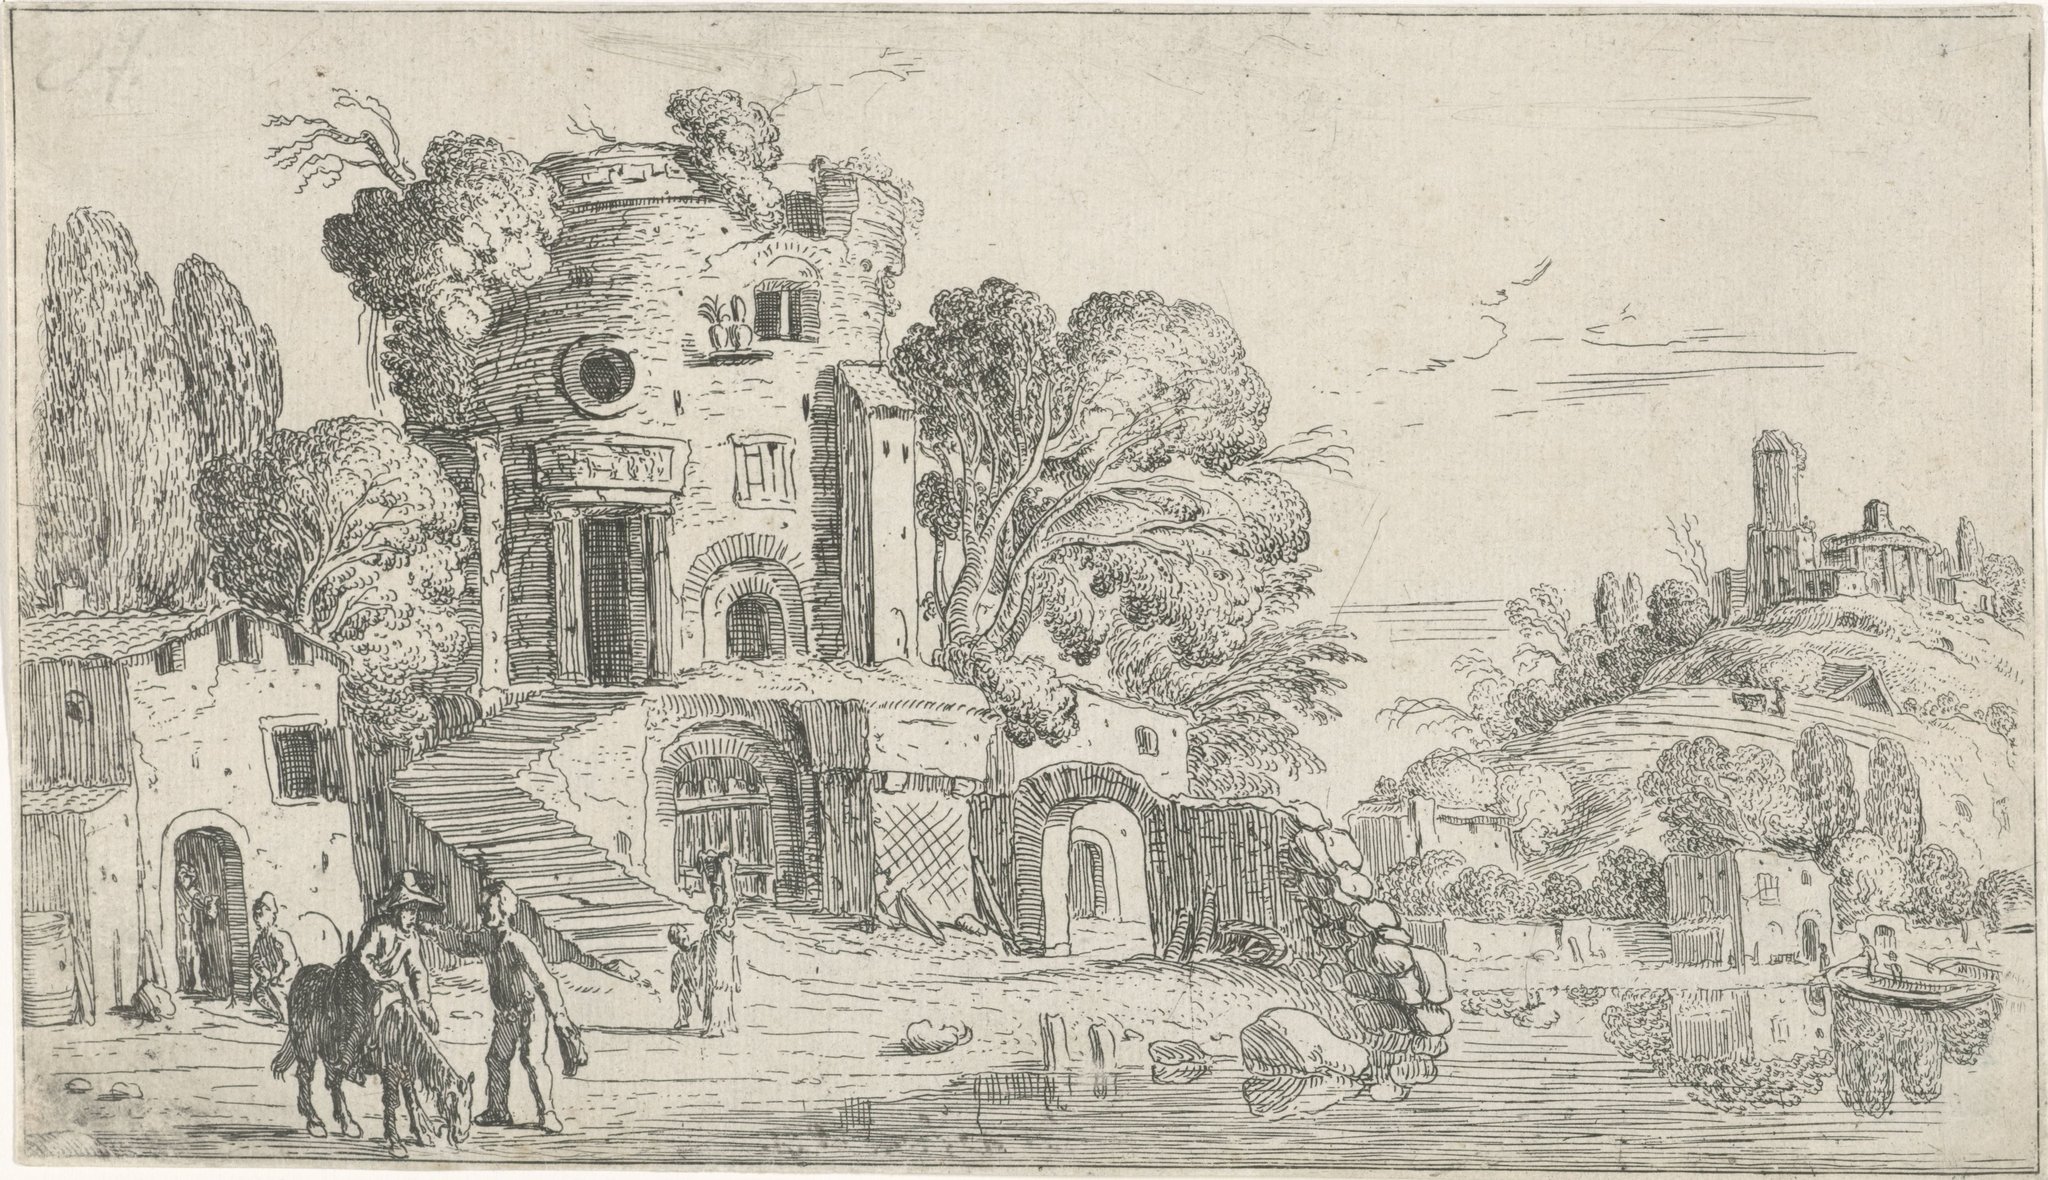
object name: print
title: Landschap met ronde toren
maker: claes moeyaert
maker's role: draughtsman, painter, print maker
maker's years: 1592-1655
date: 1612-1655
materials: paper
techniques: etching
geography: amsterdam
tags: riding a horse, ass, or mule; rider, horseman, river, landscape with ruins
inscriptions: collector's mark: Lugt 2165, collector's mark: Lugt 1684, inscription: ‘Cl. Moeyart fec: / Paisage non decrite. 1re Epreuve rare, avant le nom & l'addresse. J.F. Linck’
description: In een landschap met een ronde toren spreekt een ruiter met een man, terwijl zijn paard drinkt. Rechts een rivier met een roeiboot.